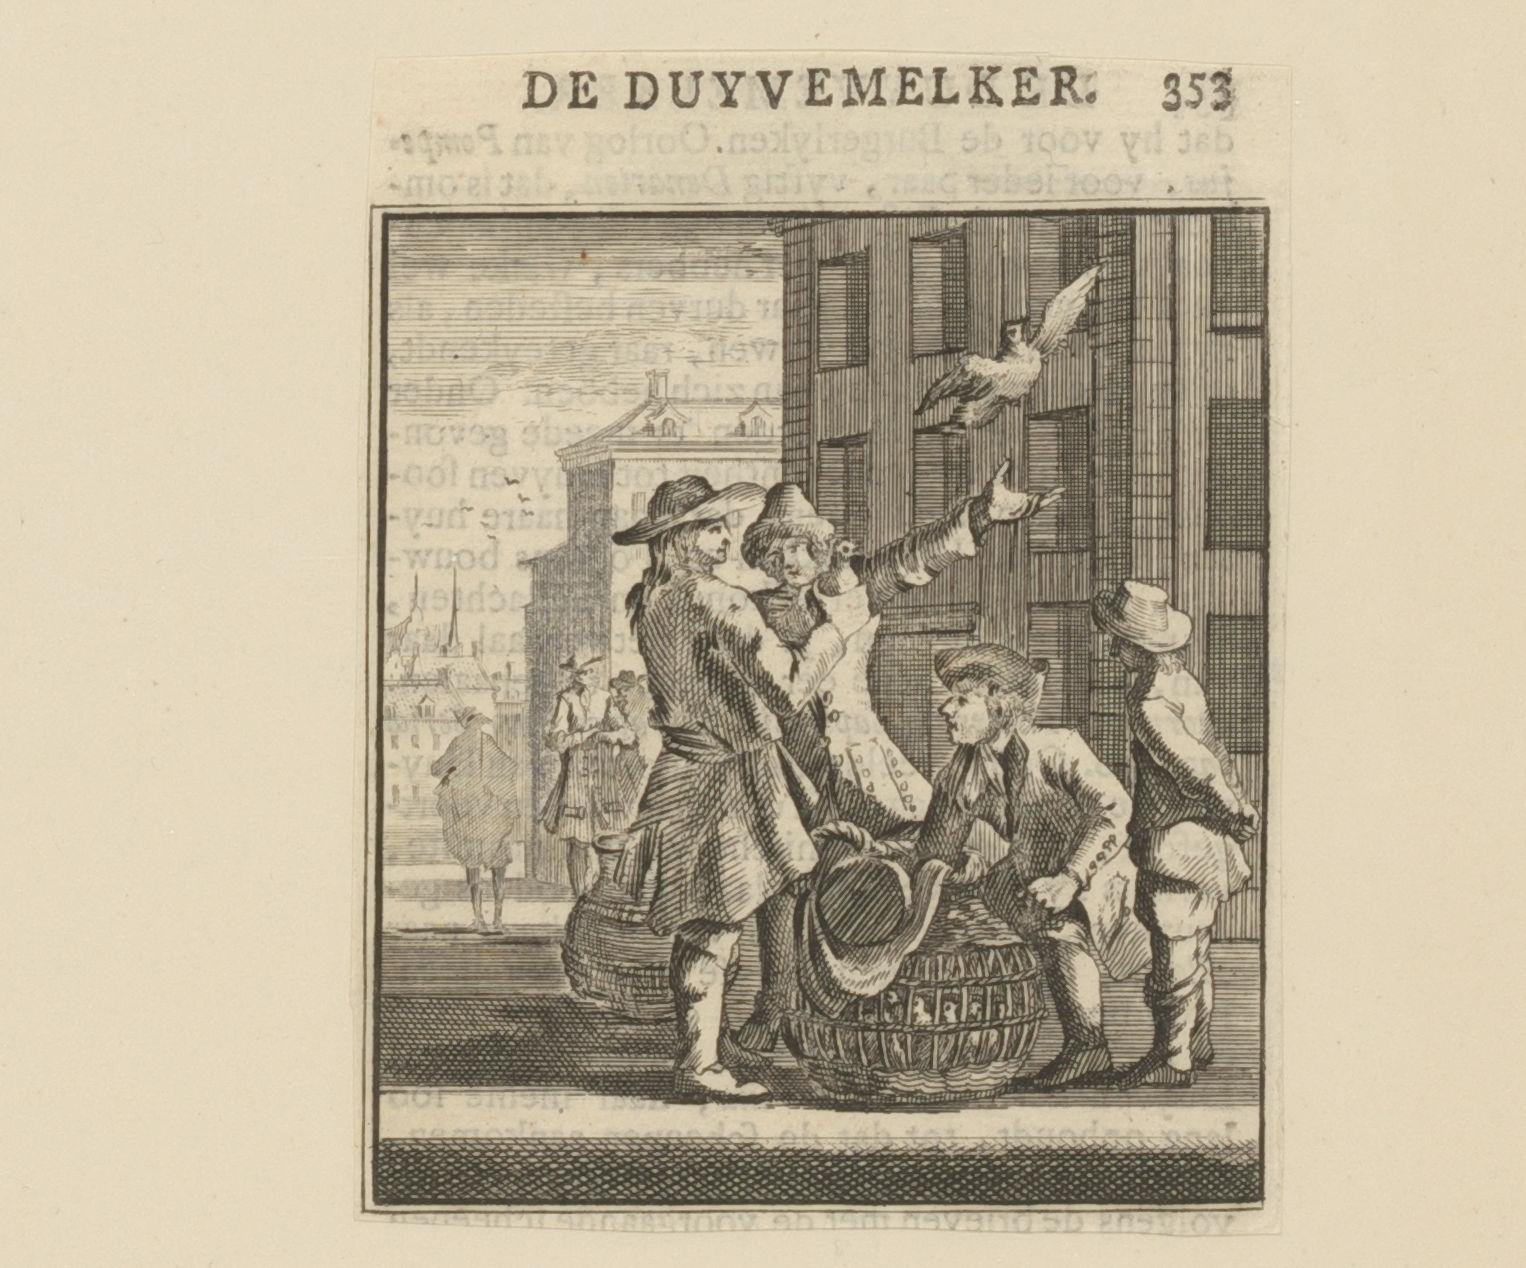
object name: print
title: De Duyvemelker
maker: Anonymous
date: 1719-1759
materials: paper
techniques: etching, letterpress printing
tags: pigeon (as messenger), pigeons (racing), doves, pigeons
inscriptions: stamp, collector's mark: Lugt 1641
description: Prent met andere letterzetting gebruikt in: St. Clara, Abraham van. Iets voor allen. [Vertaald door] J. le Long. Amsterdam: Janssoons van Waesberge, 1719, dl. 2. En in: St. Clara, Abraham van. Iets voor allen. [Vertaald door] J. le Long. Amsterdam: Jan Roman de Jonge, 1741, dl. 2. En in: St. Clara, Abraham van. Iets voor allen. [Vertaald door] J. le Long. Amsterdam: Jan Roman, 1759, dl. 2. Huidige prent uit een andere editie. Naar een prent van: Jan Luyken.